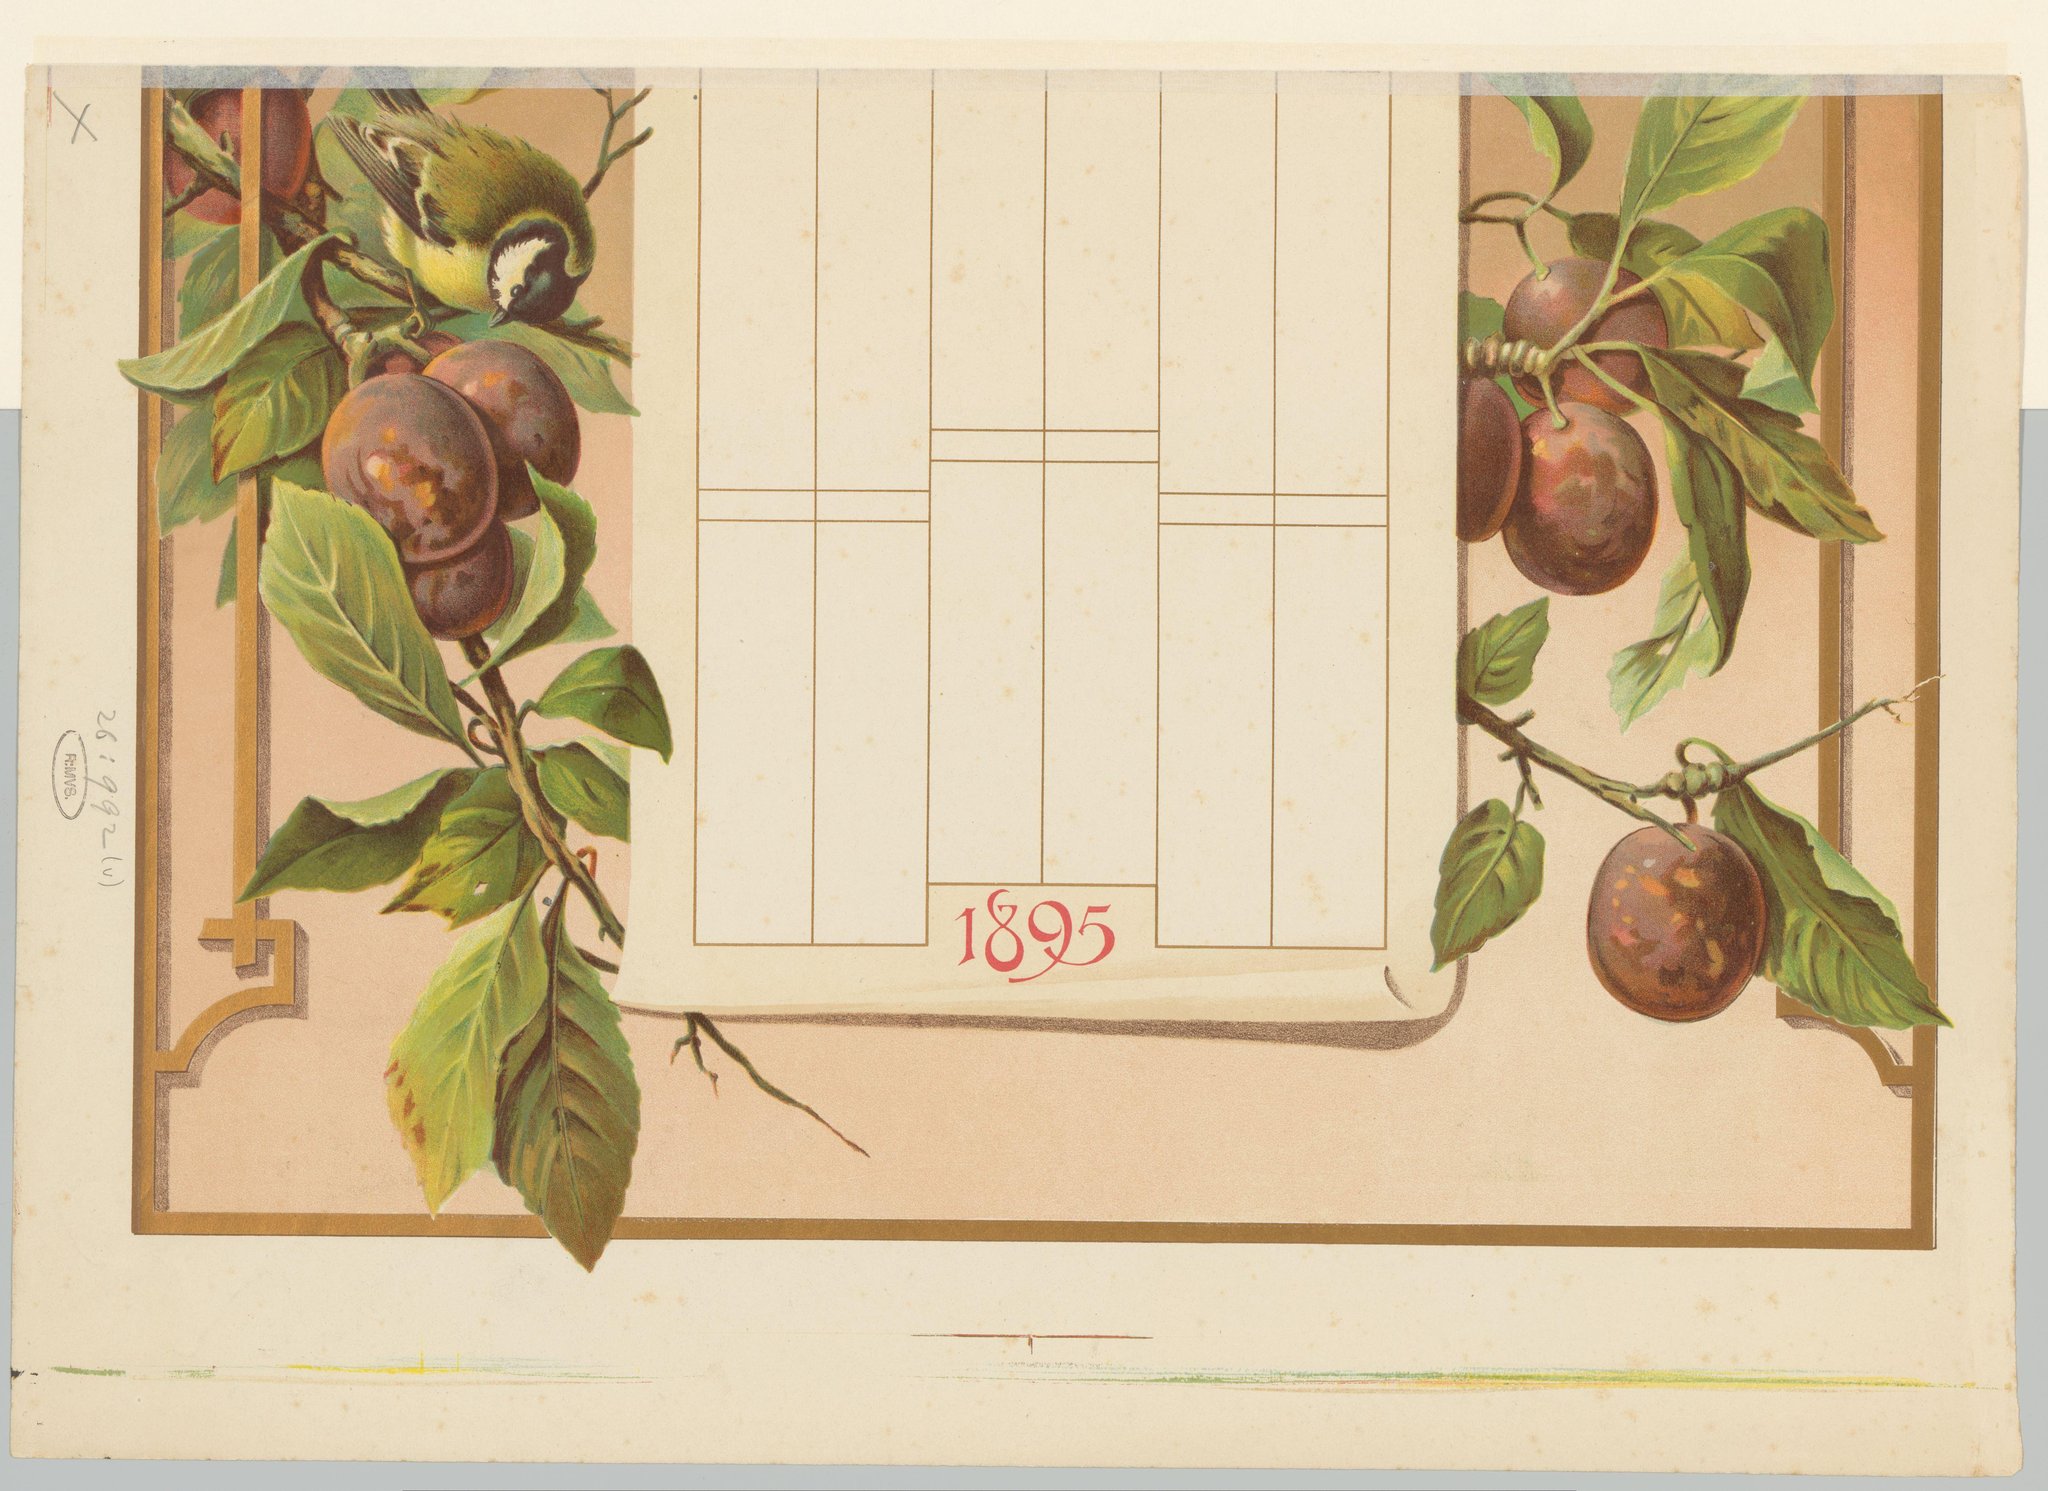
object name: print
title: Deel van een kalender voor 1895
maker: Anonymous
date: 1895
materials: paper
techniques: chromolithography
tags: fruits: plum, calendar, almanac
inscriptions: collector's mark: Lugt 2228